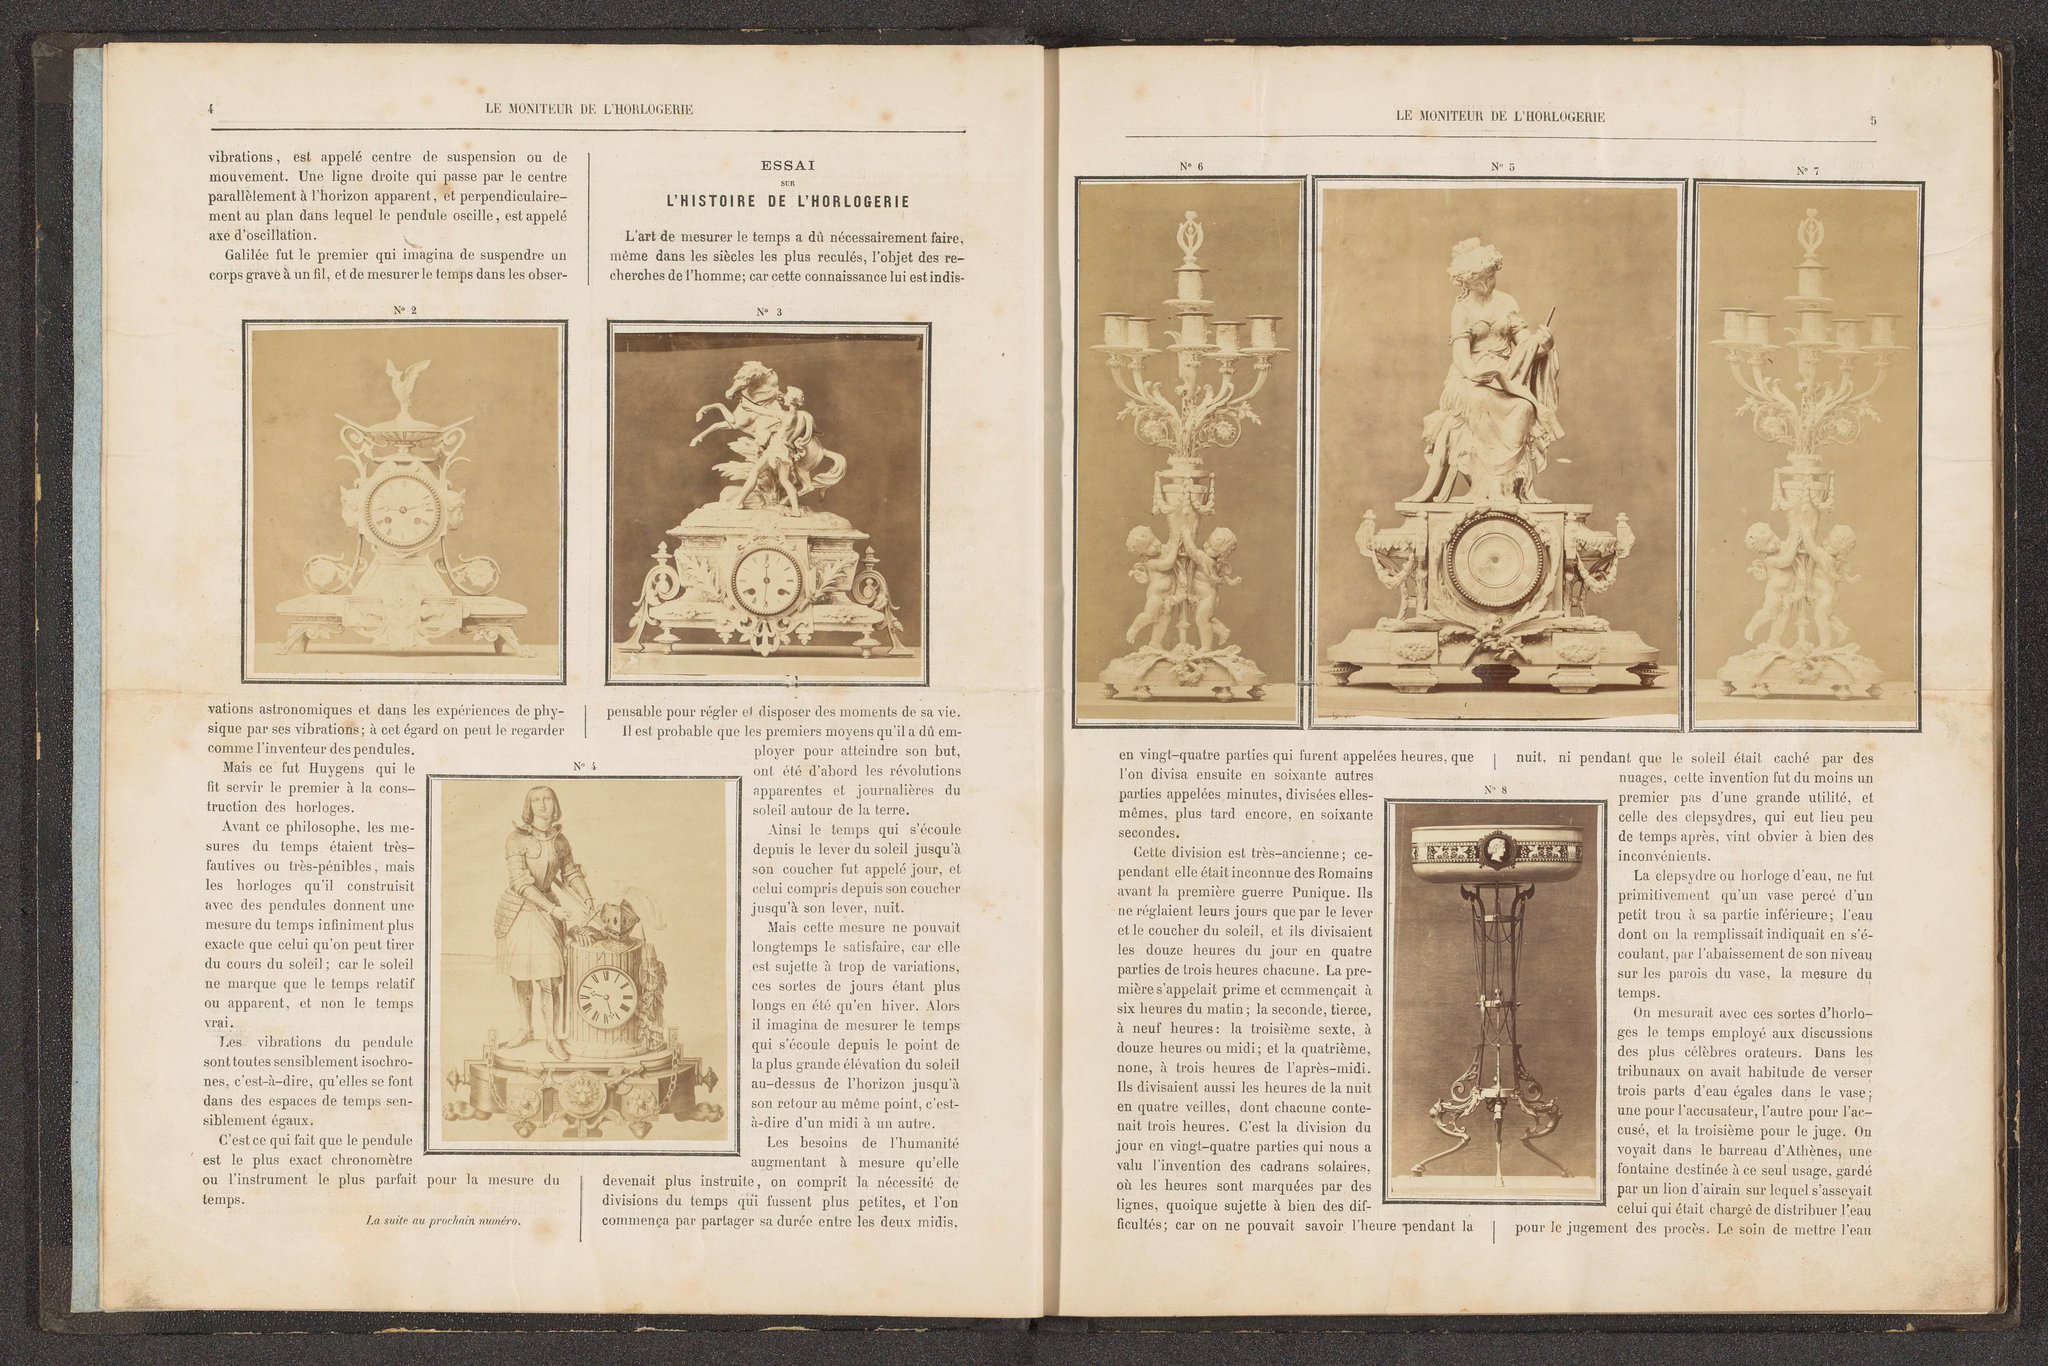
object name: page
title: Twee kandelaren, een klok en een plantenstandaard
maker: Anonymous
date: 1857-1867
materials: photographic support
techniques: albumen print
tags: clock, candlestick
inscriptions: number: ‘No 5 No 6 No 7 No 8’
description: Boven: twee kandelaren gedecoreerd met putti en een klok gedecoreerd met een vrouw door M. Lefèvre, onder: een plantenbak op een standaard gedecoreerd met een portret en fantasiewezens.